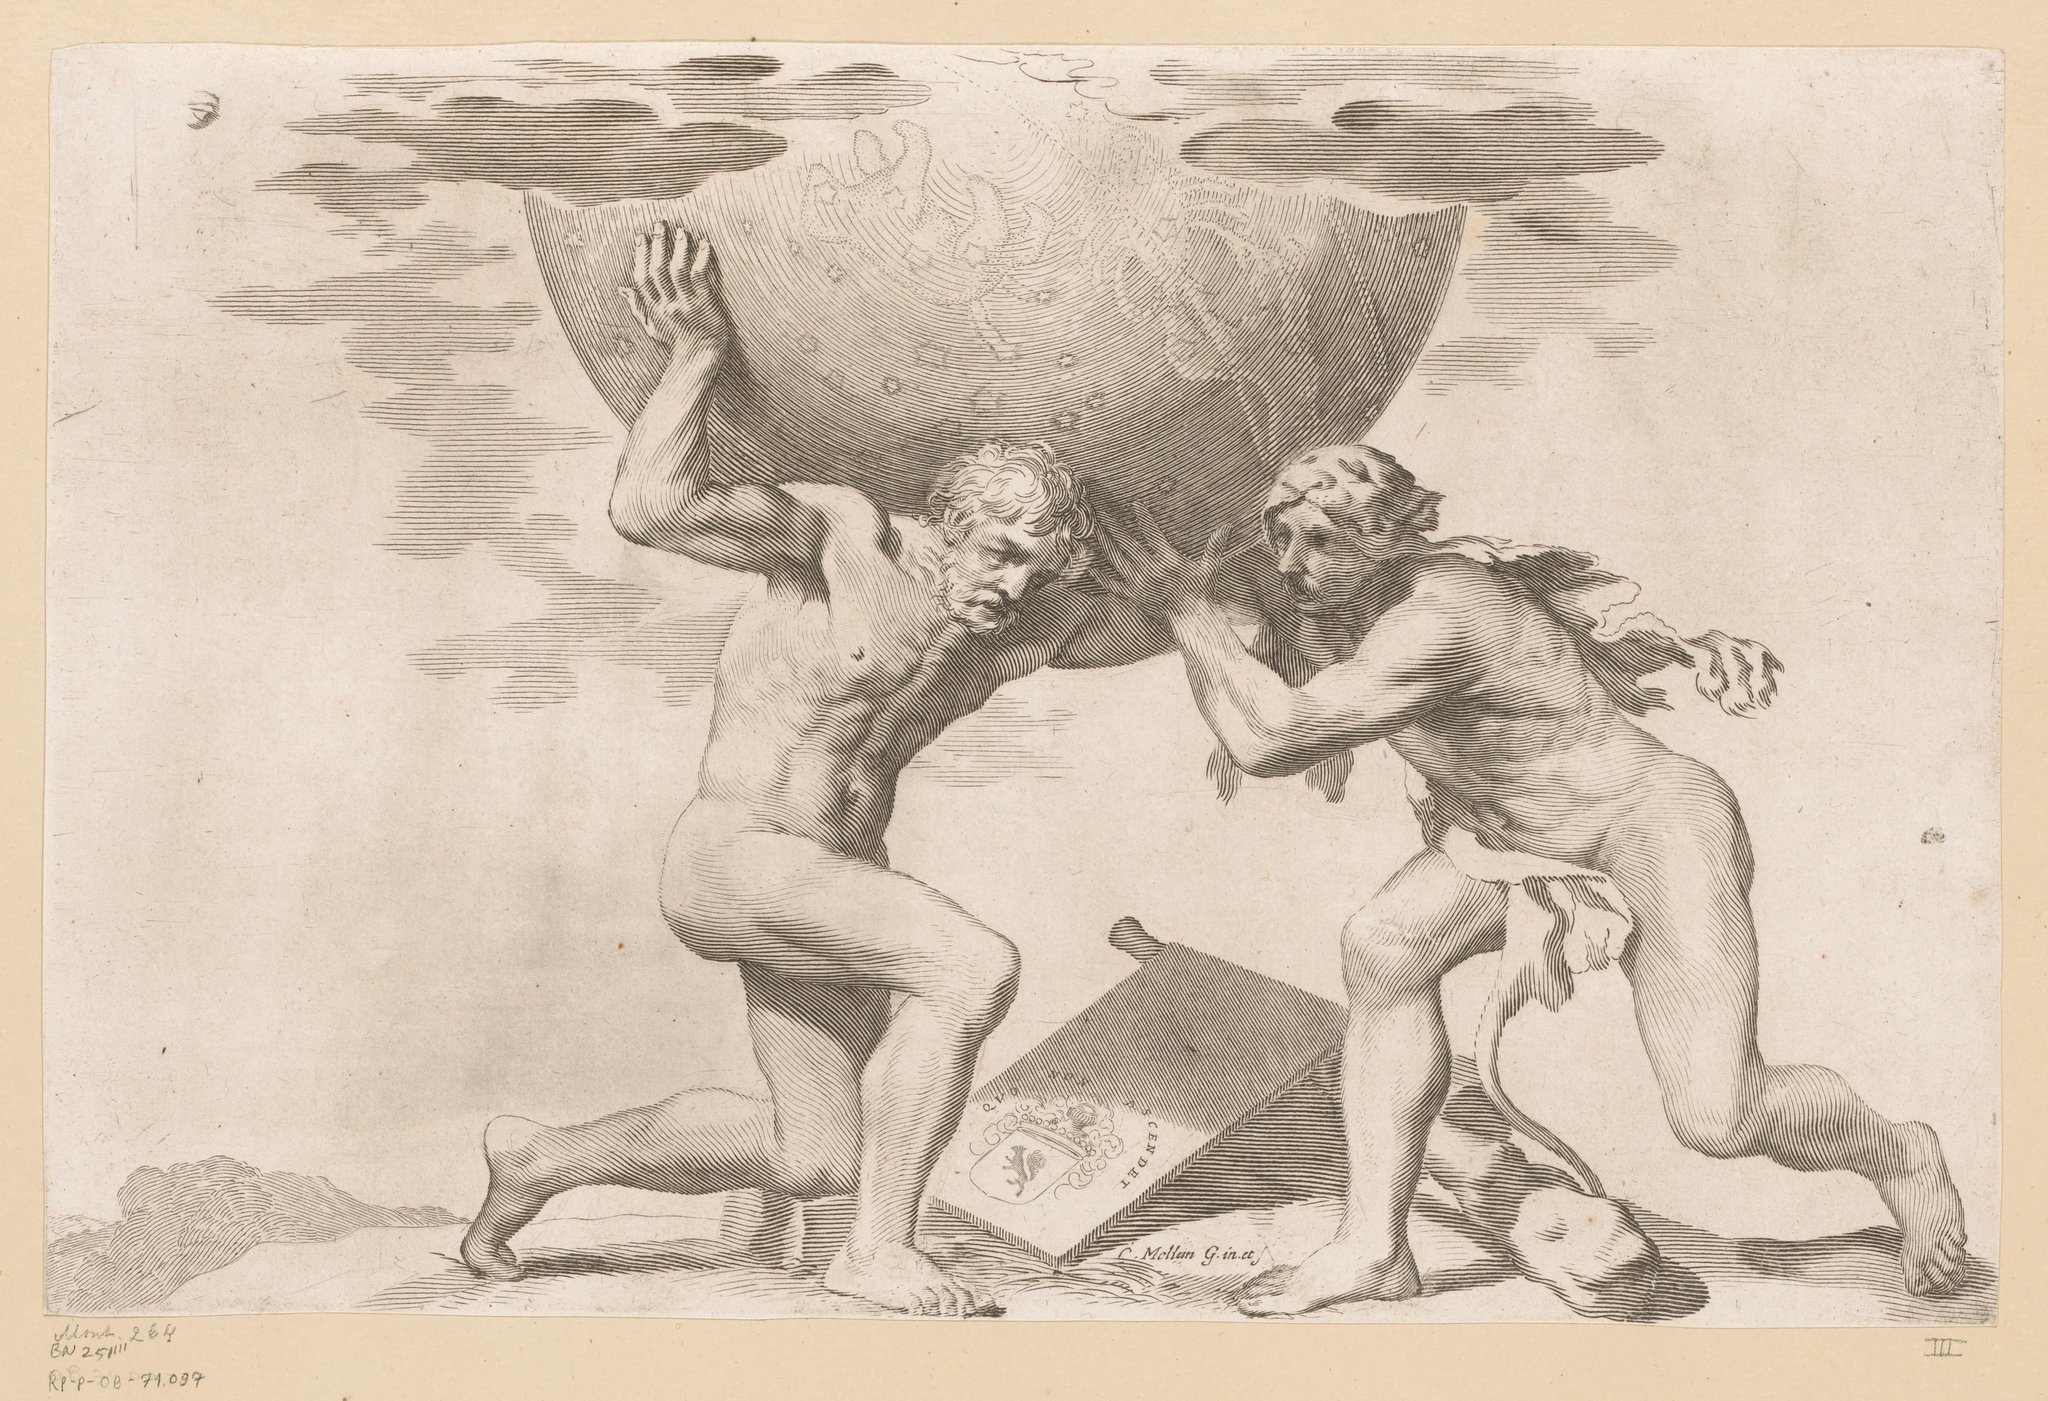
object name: print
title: Atlas geeft de hemelbol aan Hercules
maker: claude mellan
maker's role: draughtsman, print maker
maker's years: 1598-1688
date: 1651-1661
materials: paper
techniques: engraving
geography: france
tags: hercules carries the heavens on his shoulders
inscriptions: collector's mark: Lugt 240, watermark